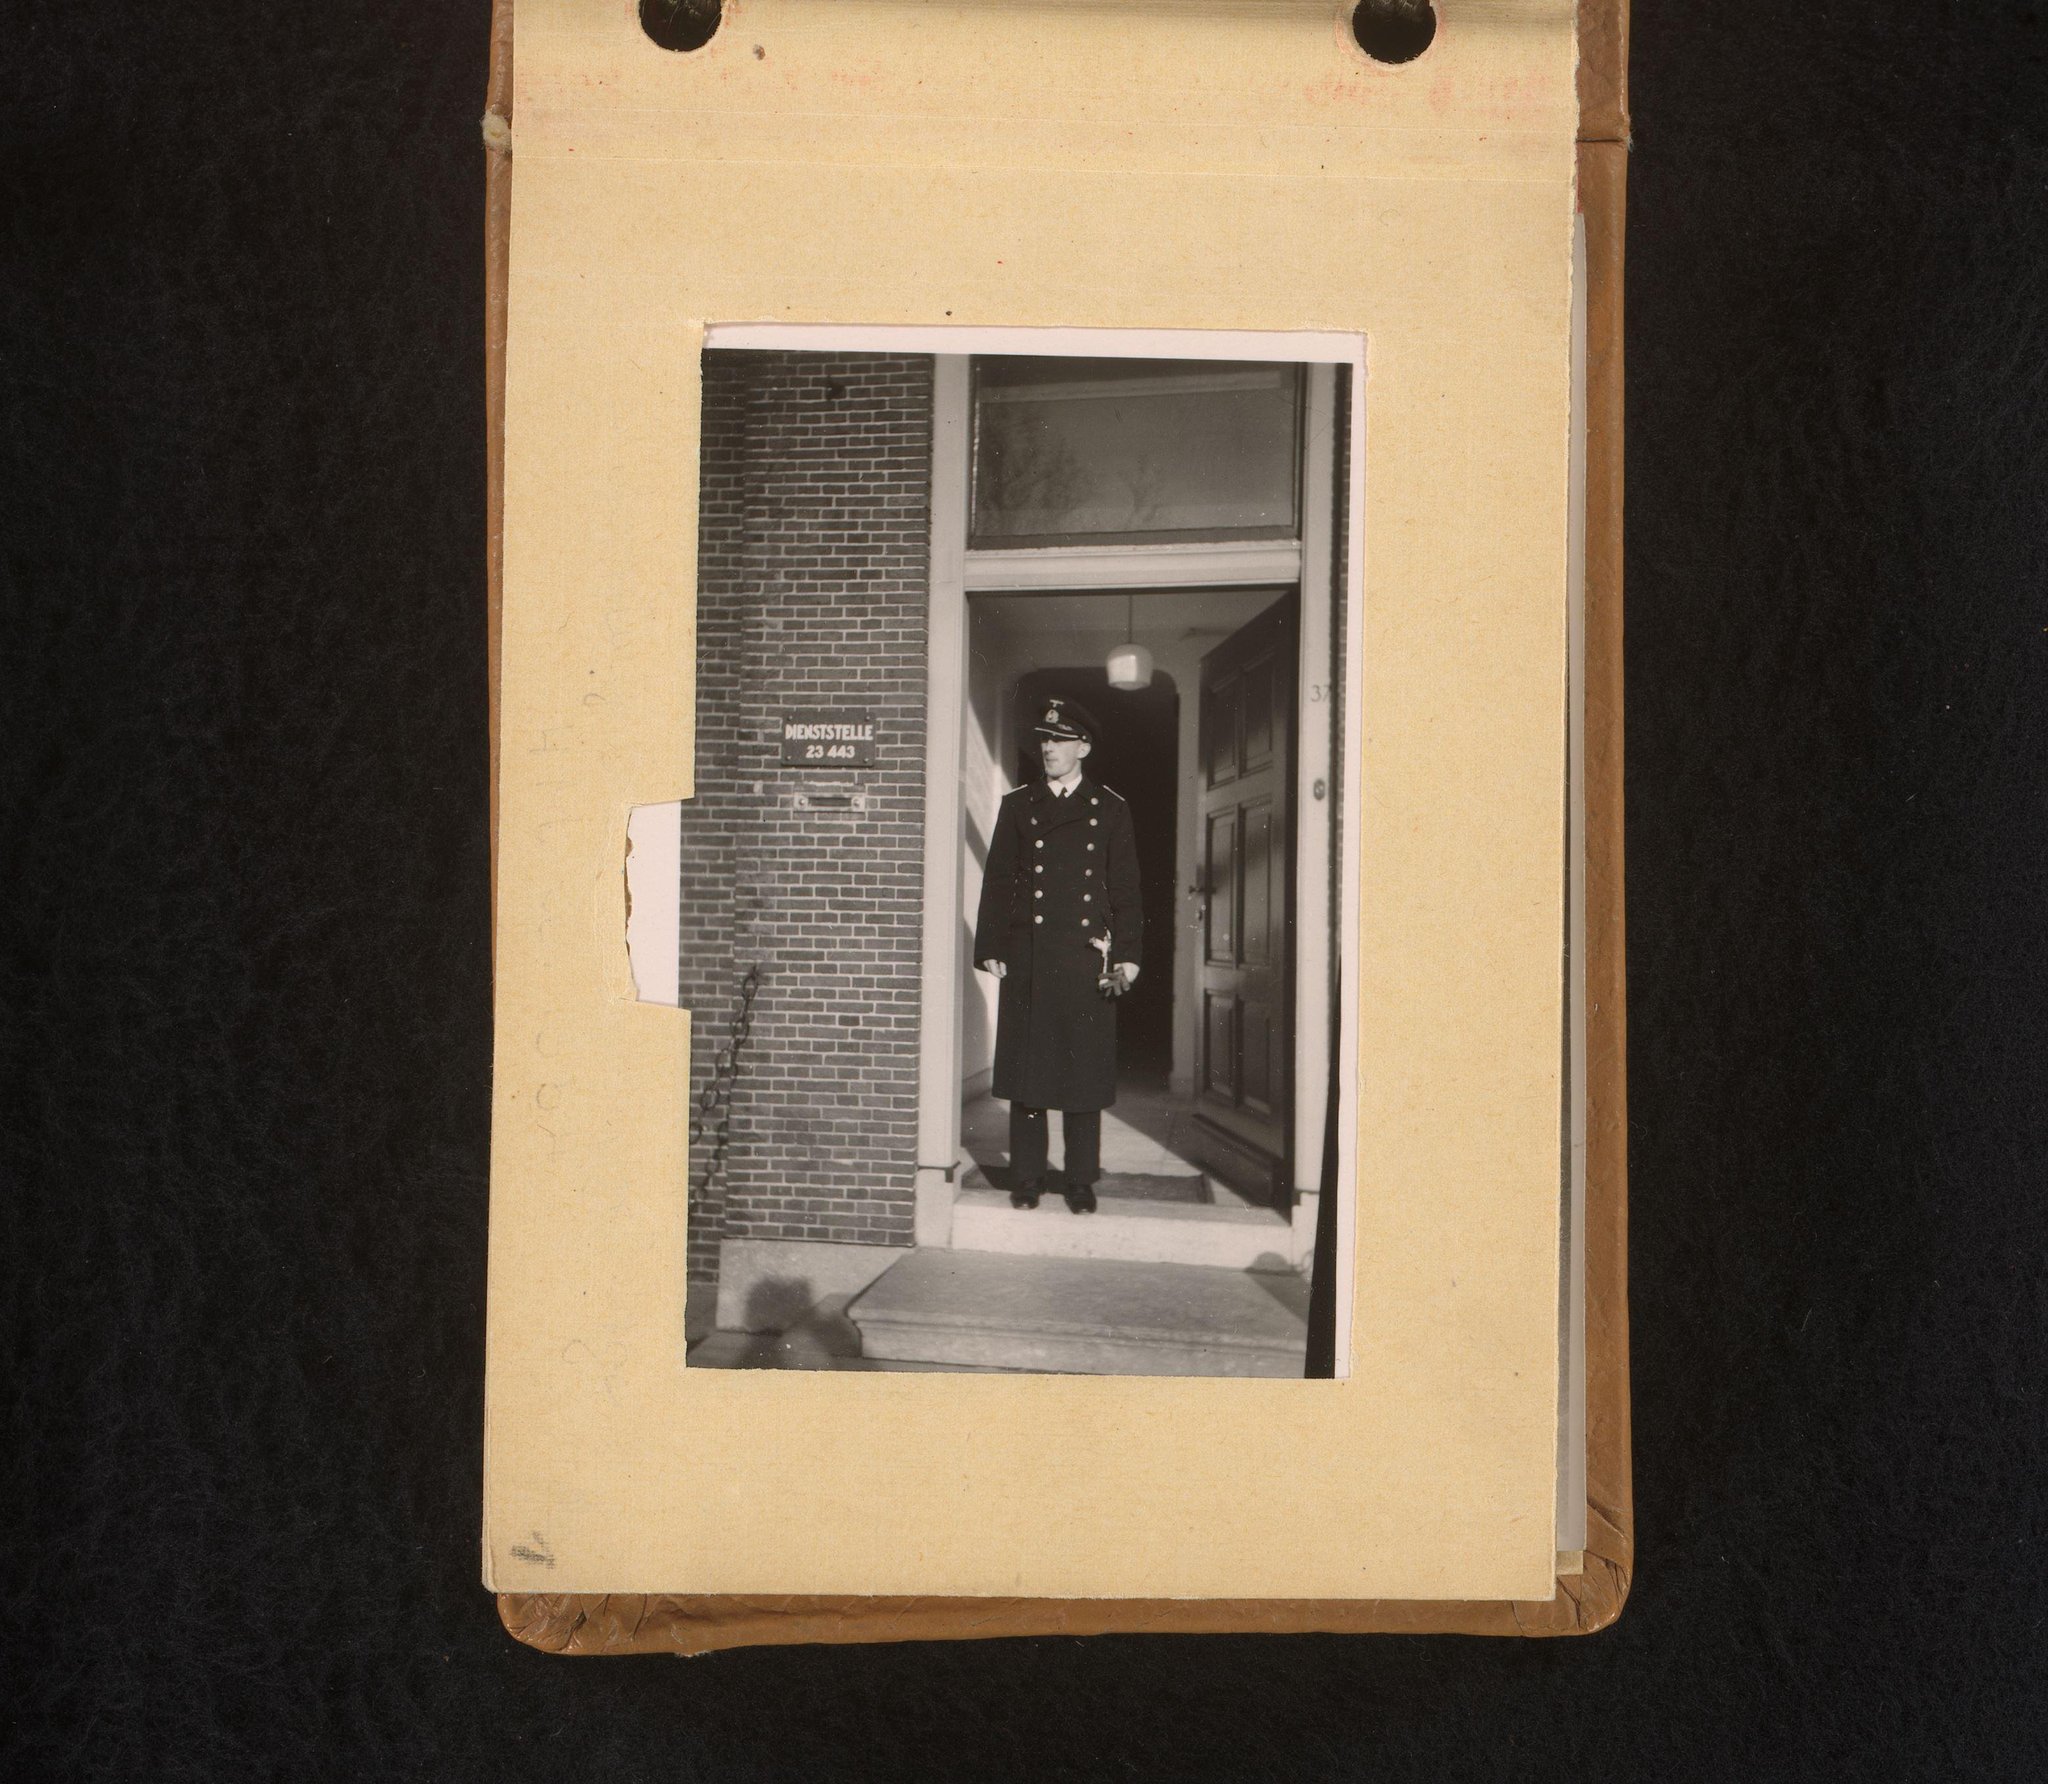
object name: photograph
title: Dienststelle 23 443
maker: Anonymous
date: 1940-1943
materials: paper, photographic support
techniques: gelatin silver print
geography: netherlands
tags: the company, the unit, the troop ~ military service, shelter ~ military service, occupation ~ war, netherlands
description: Albumblad met een foto van het onderkomen van de Kriegsmarine in Nederland: Dienststelle 23 443. De militair staande in de deuropening is waarschijnlijk de samensteller van het album. Onderdeel van een klein album van de Kriegsmarine in Nederland.